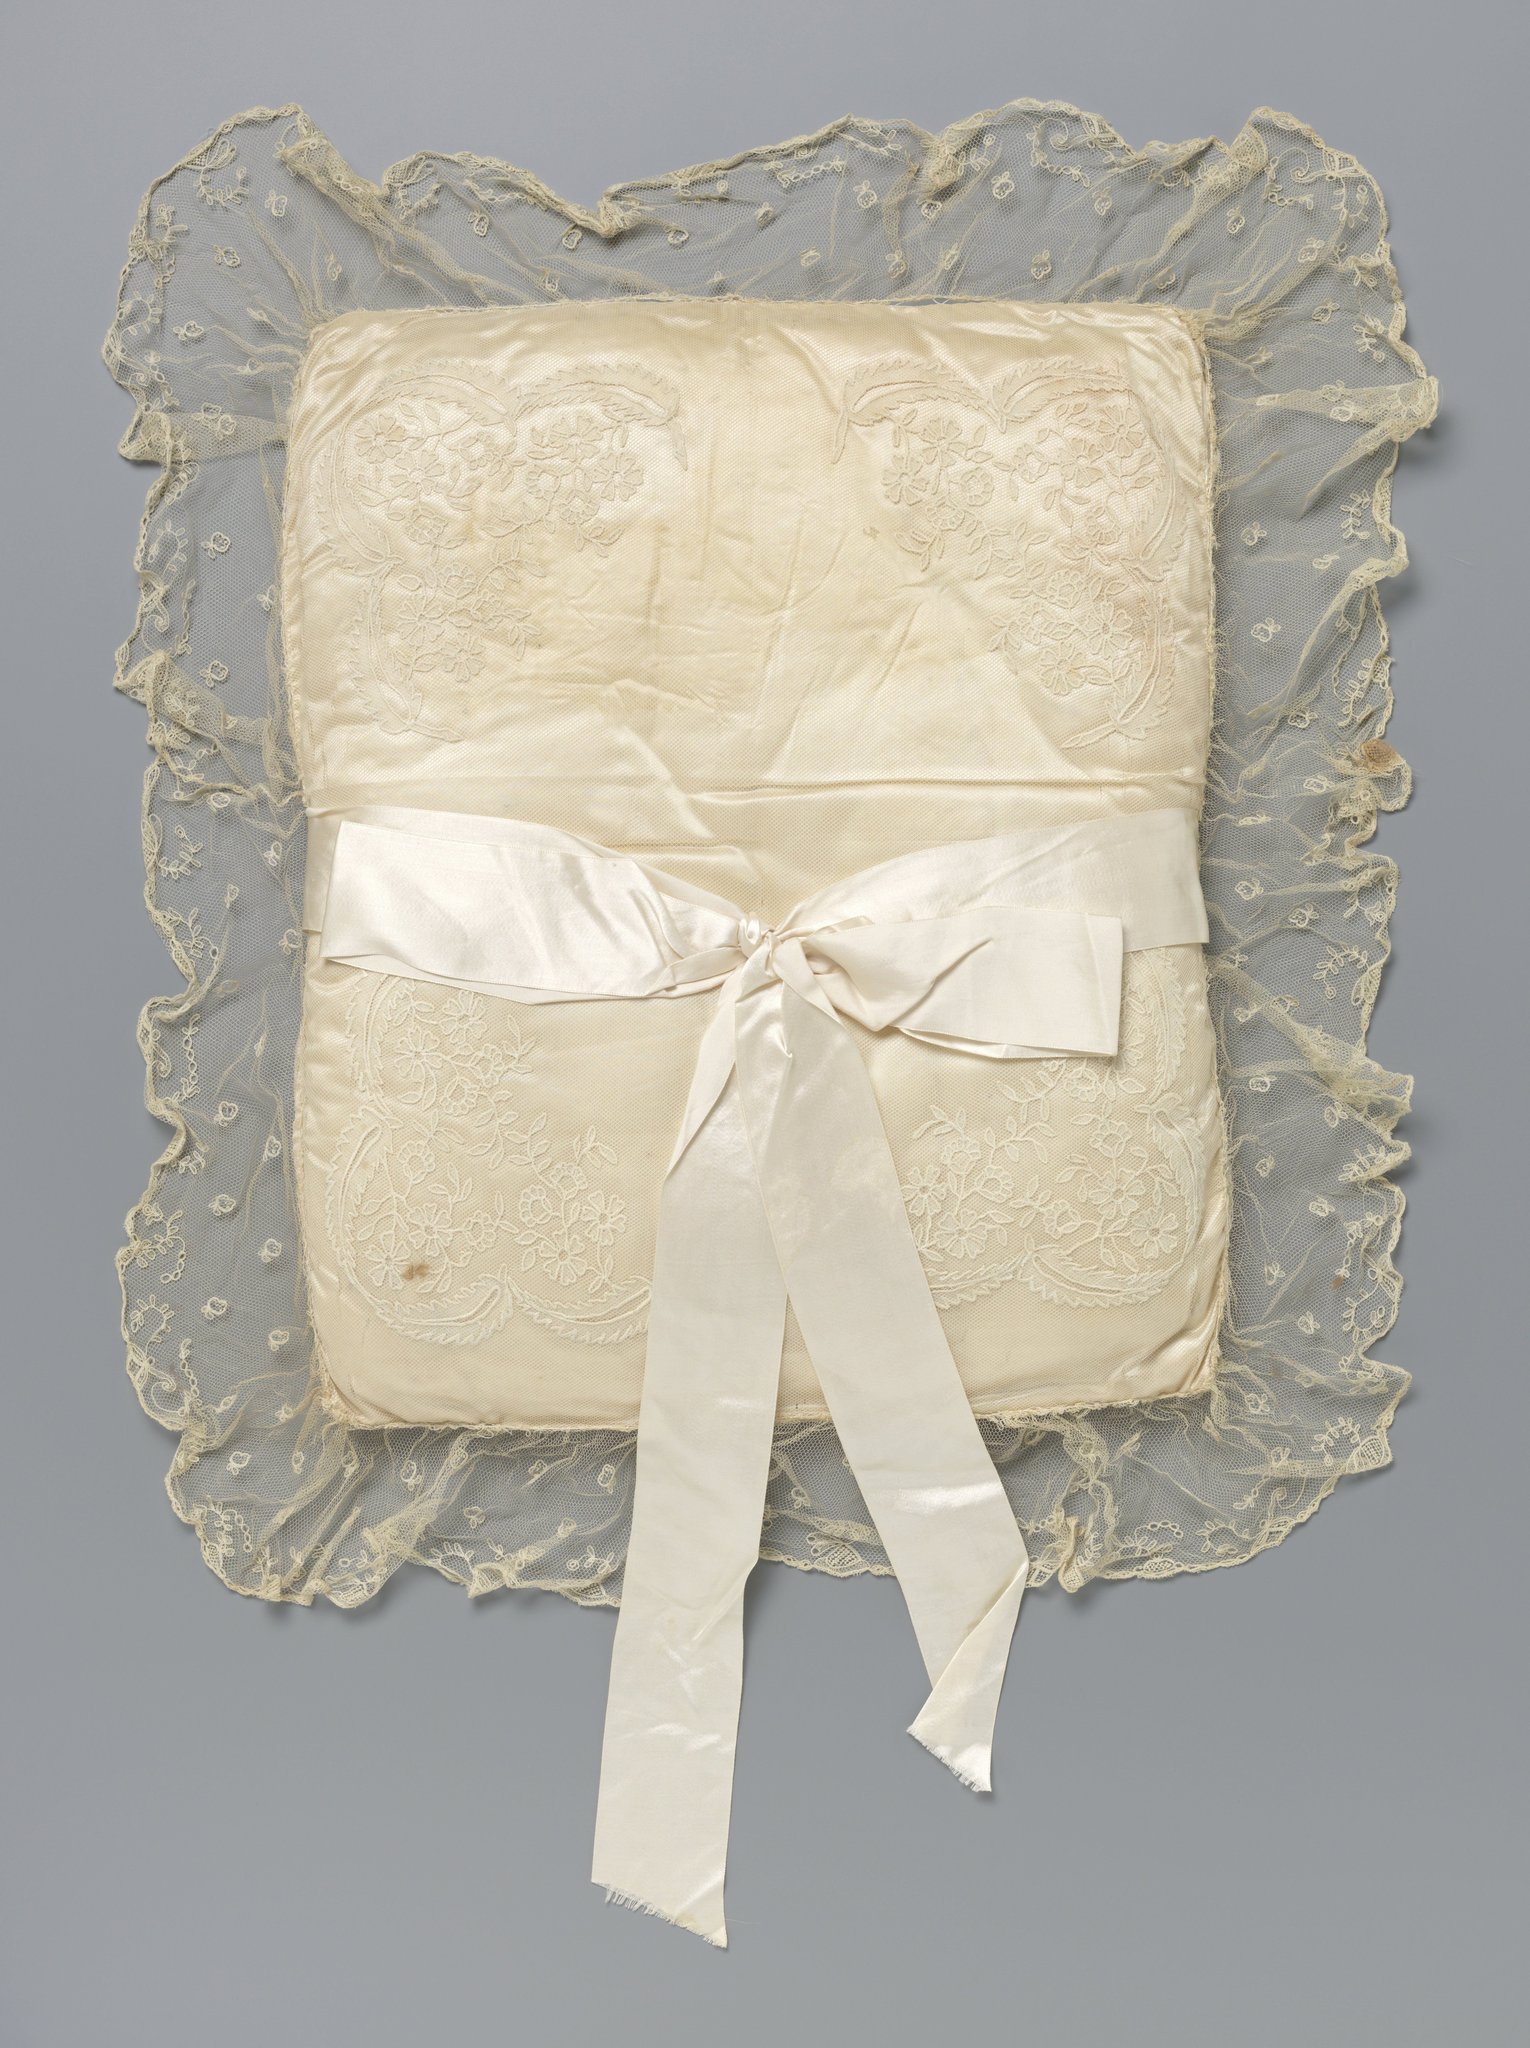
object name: doopkussen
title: Doopkussen van tuleborduurwerk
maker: Anonymous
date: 1840-1849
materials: silk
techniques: appliqué, embroidered, weave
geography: netherlands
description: Doopkussen van naturelkleurig kantborduurwerk: tuleborduurwerk op machinale tule. Langs de randen tamboereerwerk op machinale tule en in de hoeken zijn applicaties aan de tule bevestigd, boven de voering van crèmekleurige zijden satijn. Rechthoekig model, opgevuld. De applicaties betreffen per hoek drie bloemtakken met aan iedere tak twee rozetbloempjes en twee klokbloempjes. Om de bloemtakken is met vier gevederde bladeren een v-vormig kader gerealiseerd. De applicaties zijn gemaakt door bloemen te borduren op een stuk batist met festonsteken en cordonsteken. Mogelijk is steeds een heel stuk batist vastgezet aan de tule en zijn pas daarna delen batist weggeknipt, de vorm volgend van de geborduurde motieven. De strook langs de rand is met weinig fijne plooitjes vastgezet, in de hoeken sterker geplooid. Onder het kussen loopt een breed crèmekleurig lint door, die aan twee tegenoverliggende zijden van het kussen is vastgenaaid. De lange loshangende uiteinden van het lint dienen ervoor om over het kinderlijf te worden gestrikt. Het kussen wordt met een gestrikt lint bewaard.